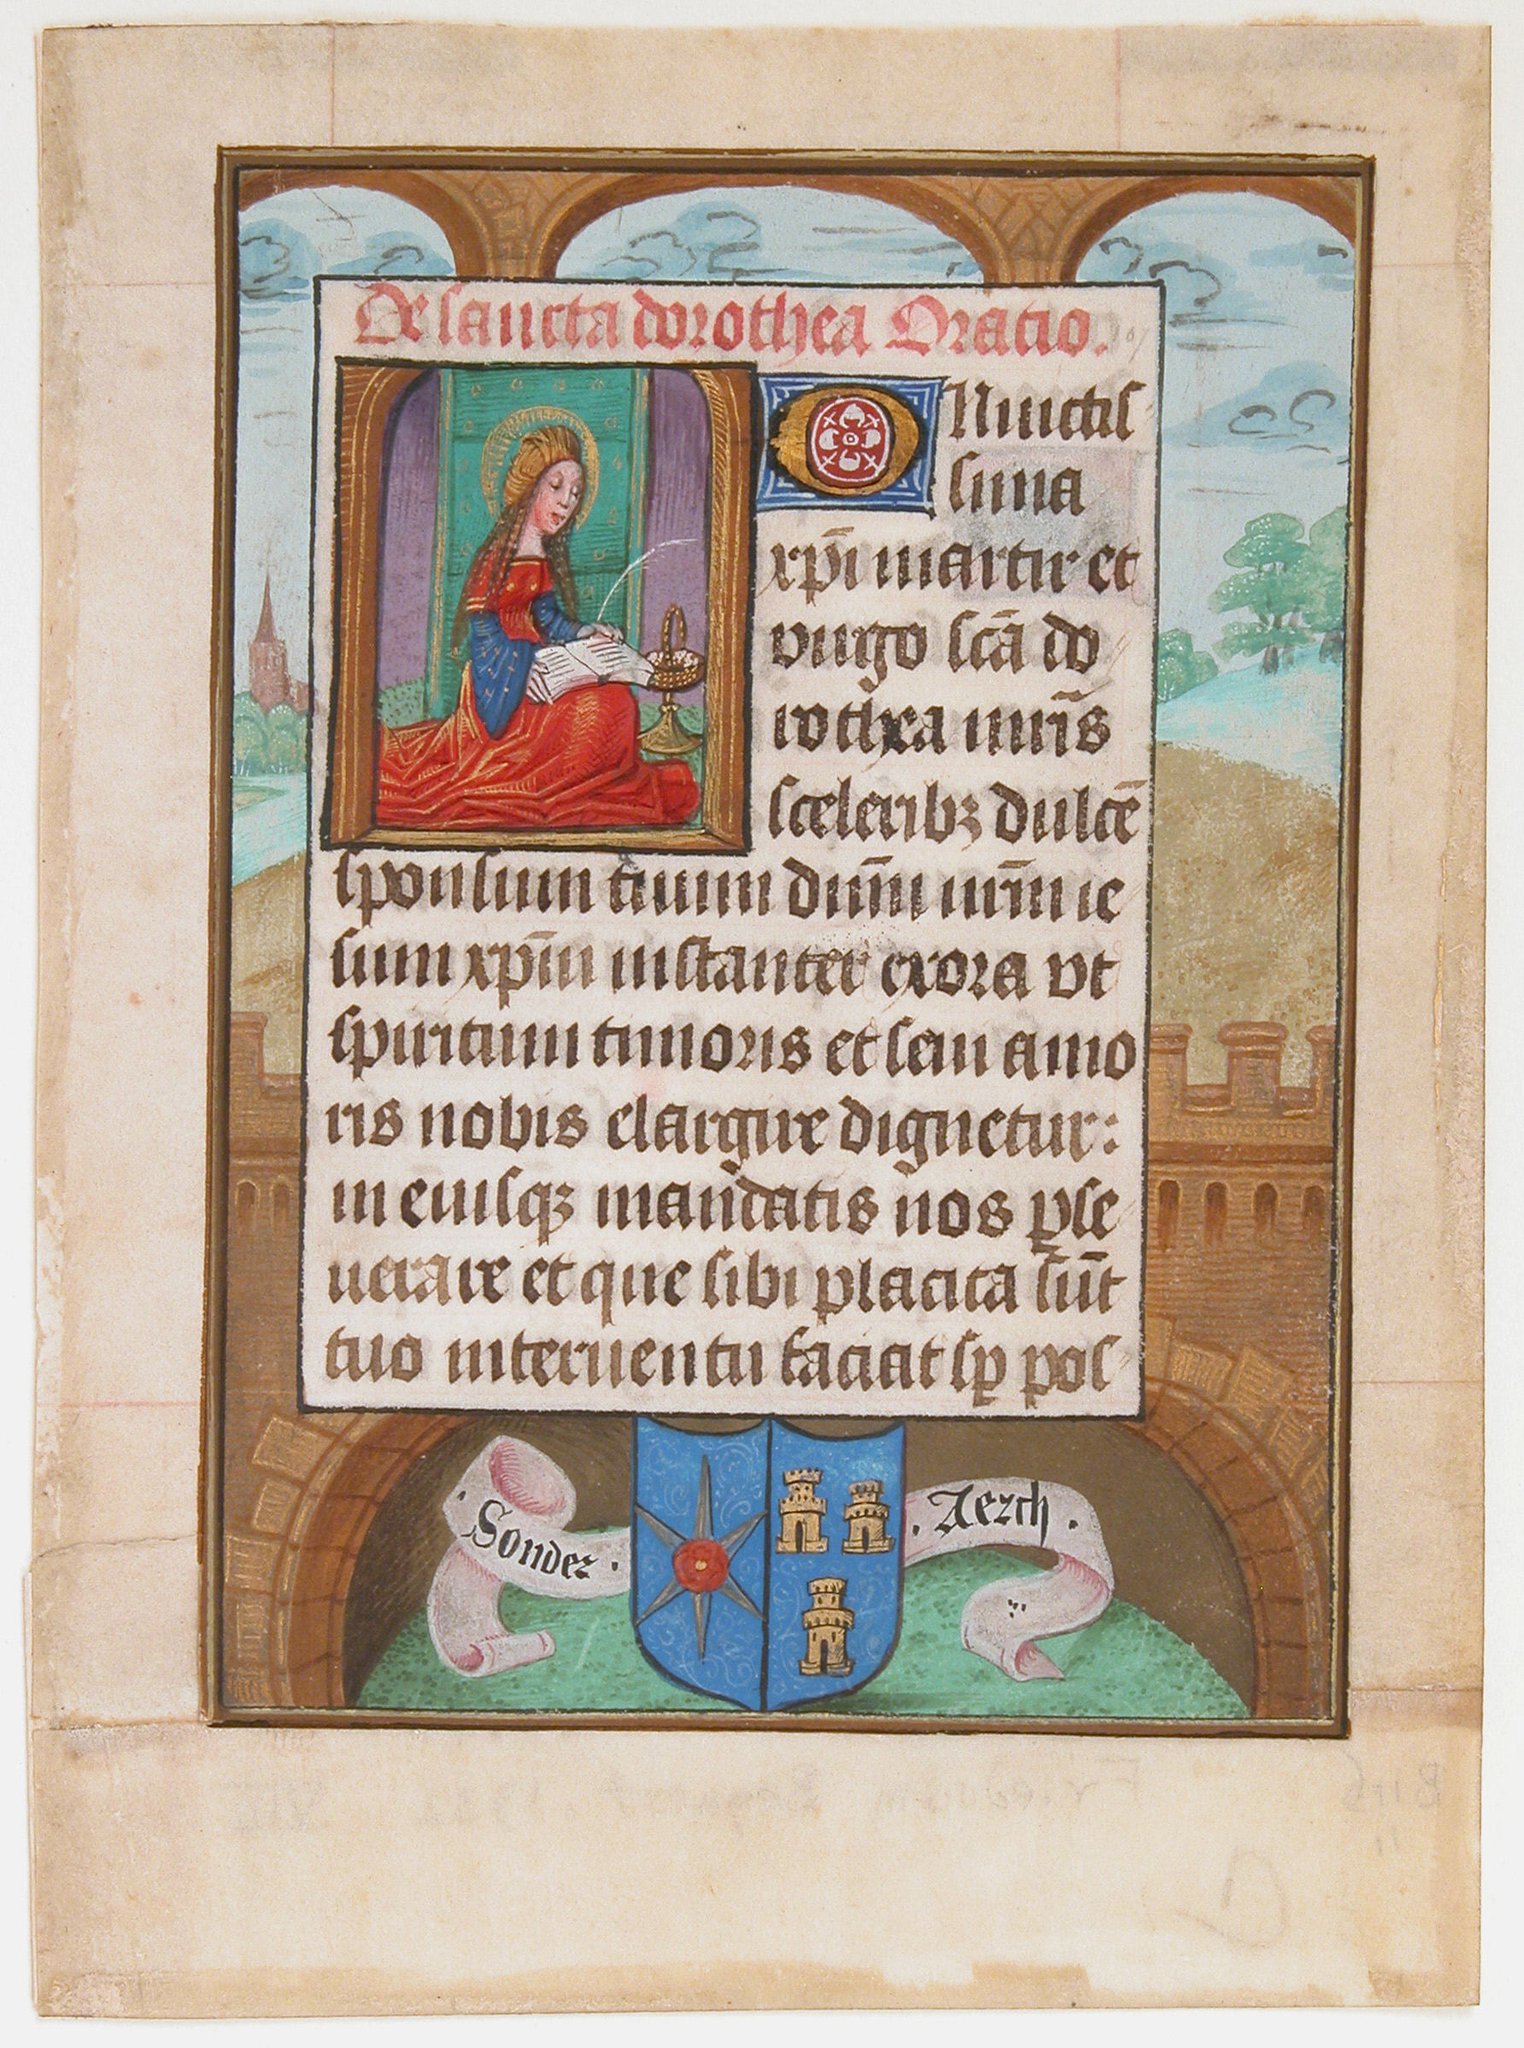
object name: book of hour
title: Manuscript Leaf wtih Saint Dorothy, from a Book of Hours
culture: dutch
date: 1500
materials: gold, ink, parchment, shell, paint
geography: netherlands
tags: women,saints,coat of arms